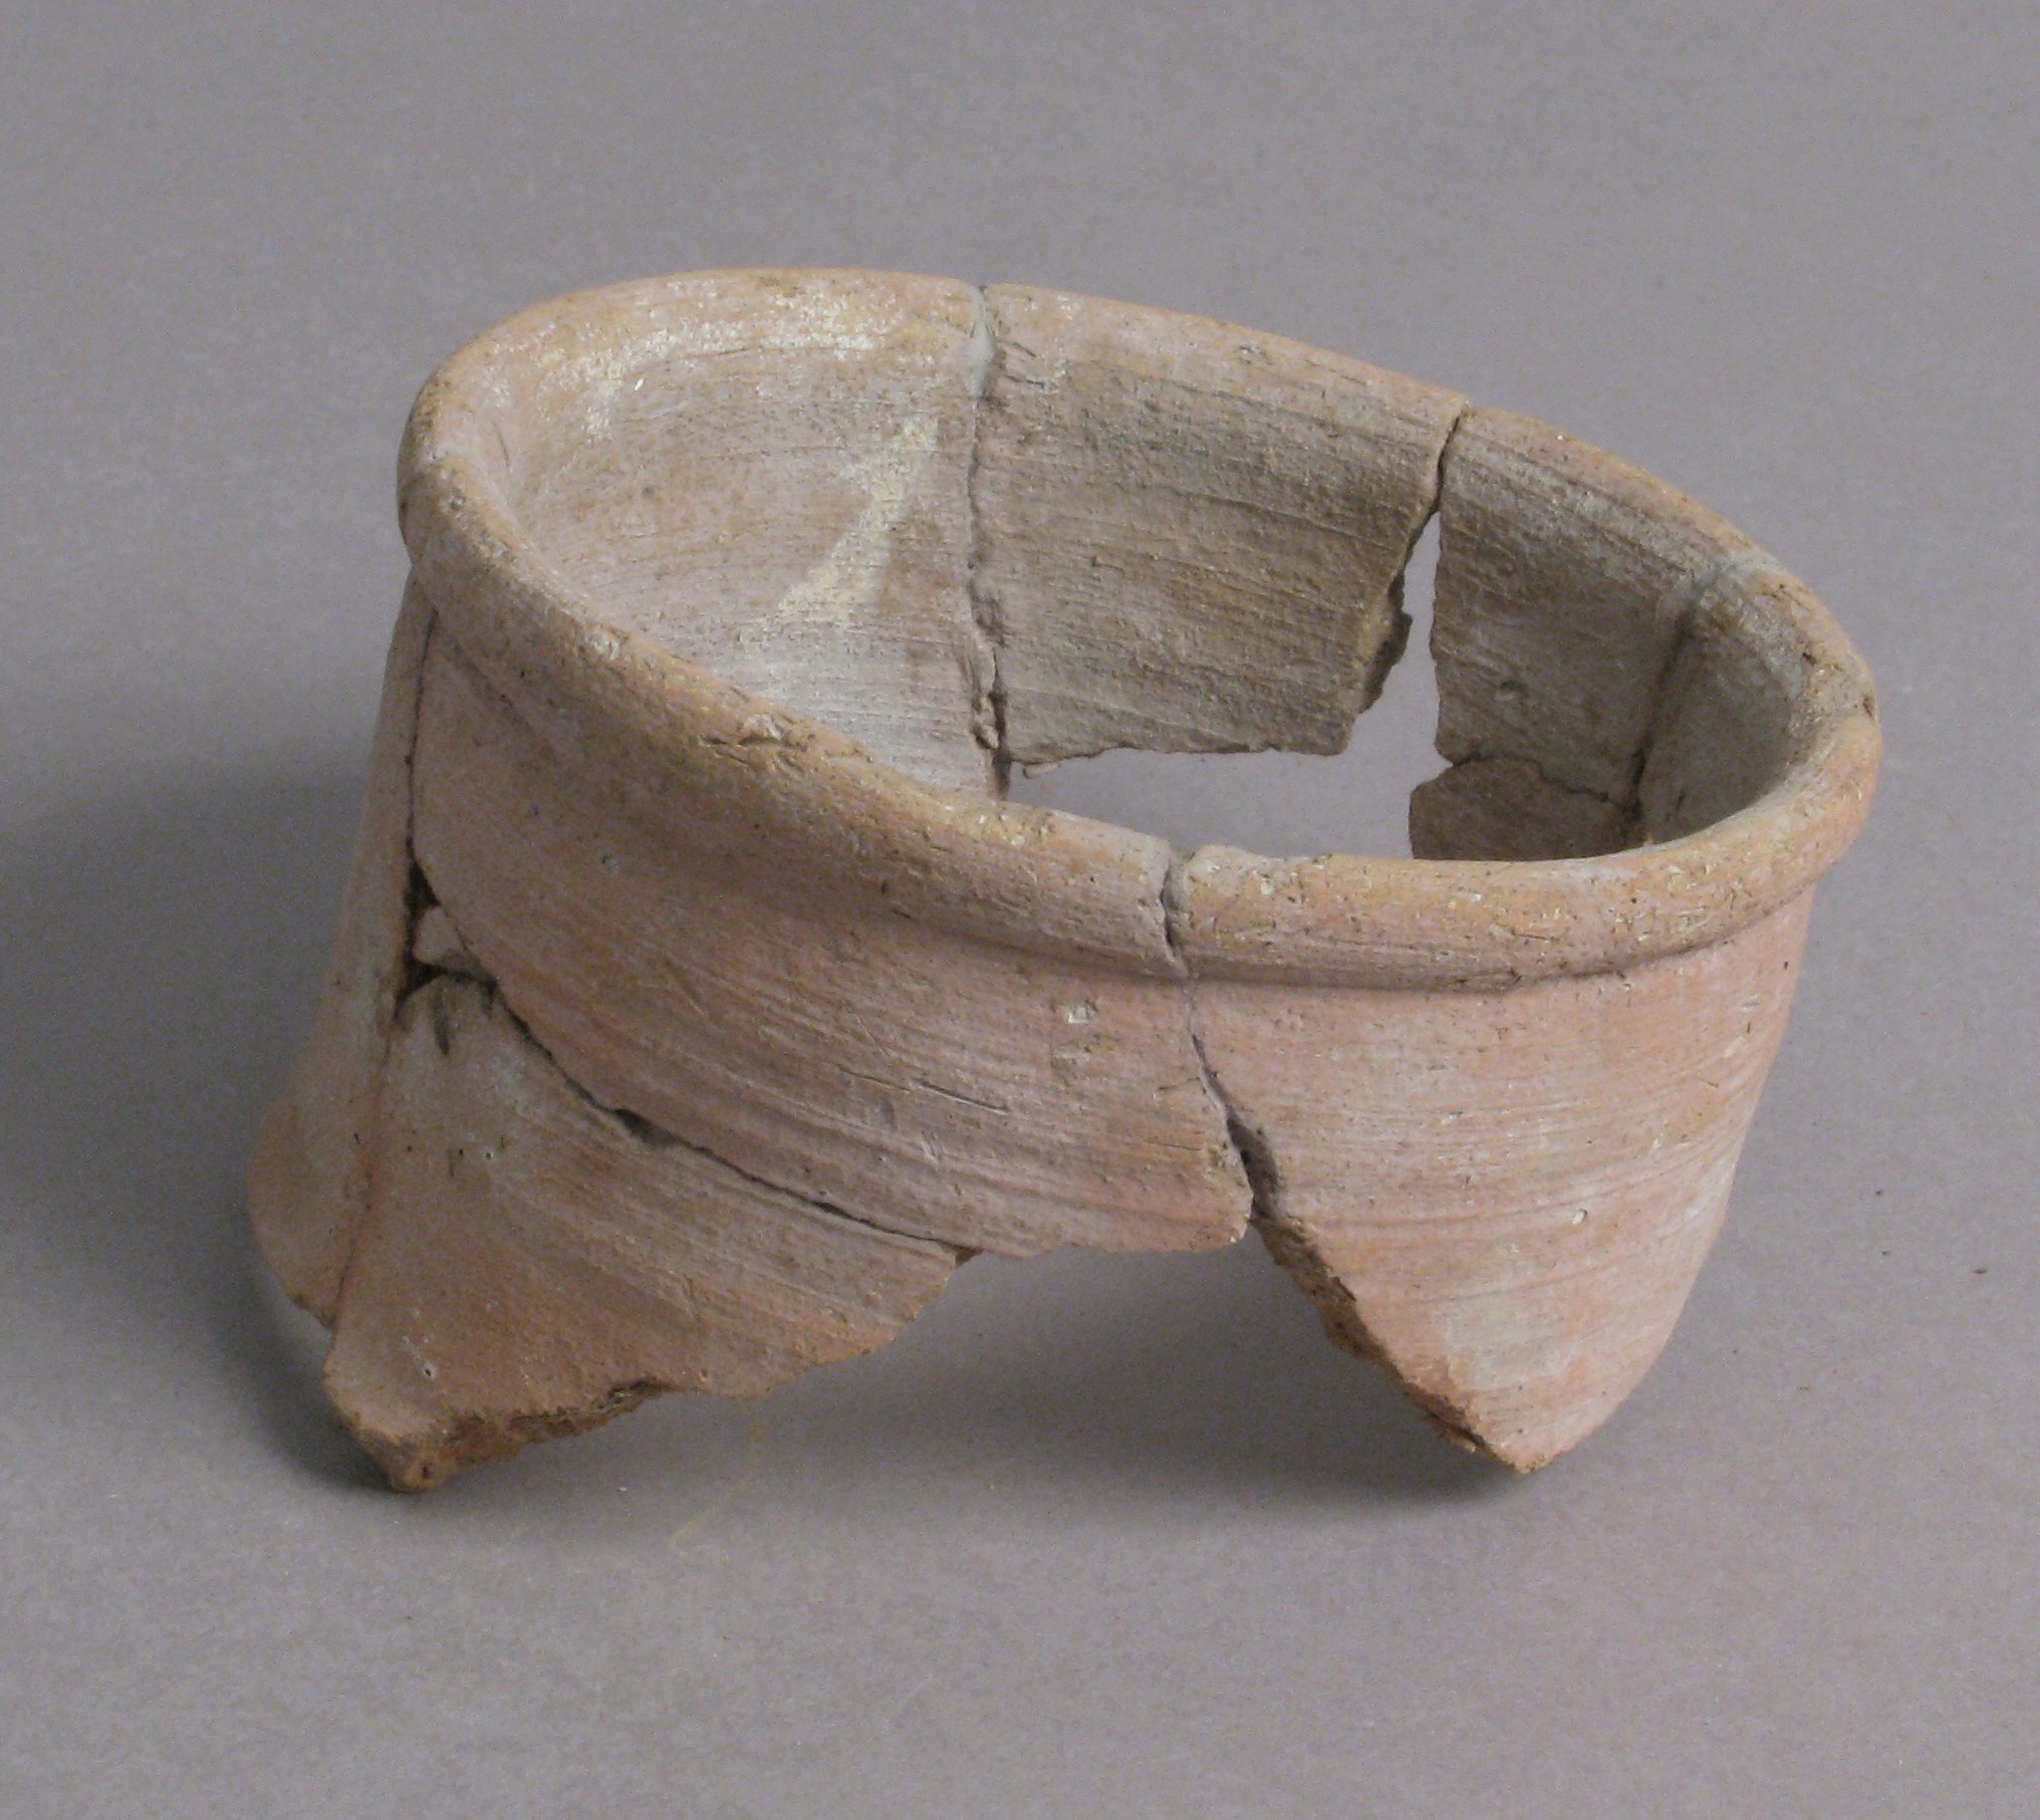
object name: fragment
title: Fragment of a Pot Neck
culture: coptic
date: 301-700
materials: earthenware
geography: egypt